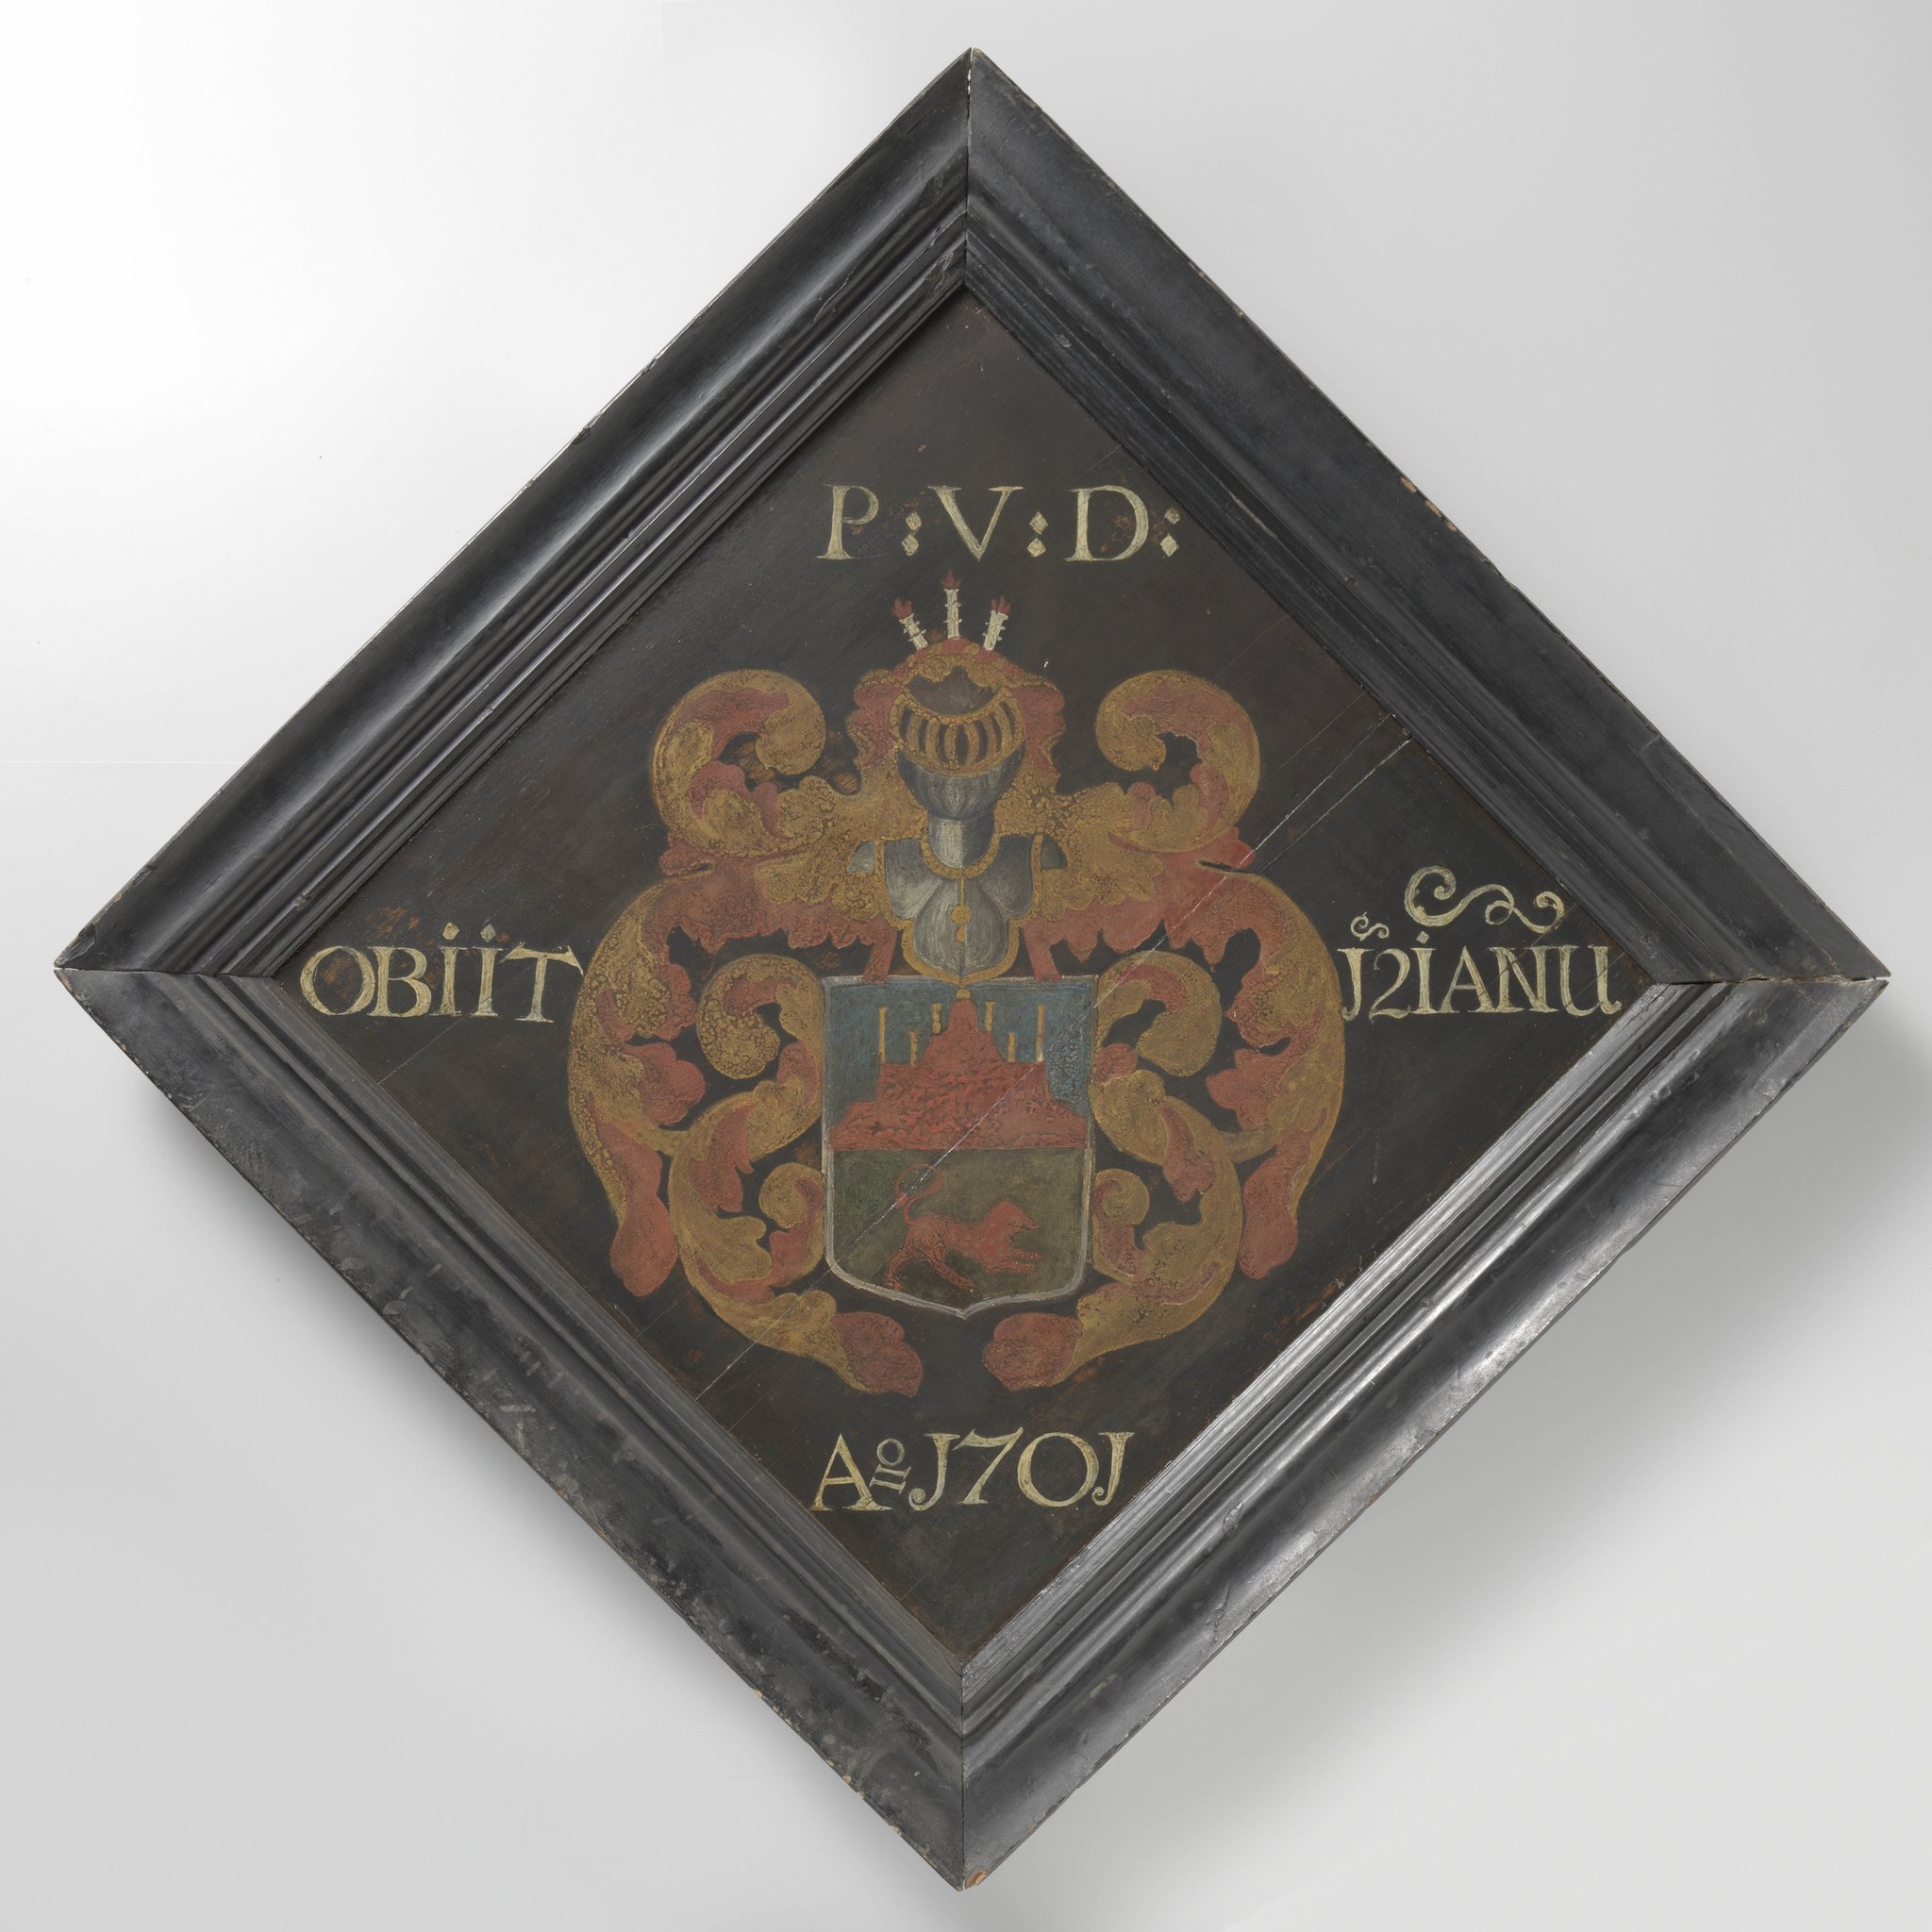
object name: rouwbord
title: Grafbord van Pieter van Dishoeck (1653-1701), directeur van Bengalen (1696-1701)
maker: Anonymous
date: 1767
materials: panel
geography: bengal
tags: armorial bearing, heraldry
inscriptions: inscription: ‘P:V:D: OBIIT 12 IANU Ao 1701’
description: Grafbord van Pieter van Dishoeck. Ruitvormig grafbord van Indiaas hout met zwart geschilderde geprofileerde houten lijst, beschilderd met op zwarte grond een wapen met helm, dekkleden en als helmteken drie brandende kaarsen of toortsen. Opschrift in gele letters: 'P:V:D: OBIIT 12 IANU Ao 1701'.